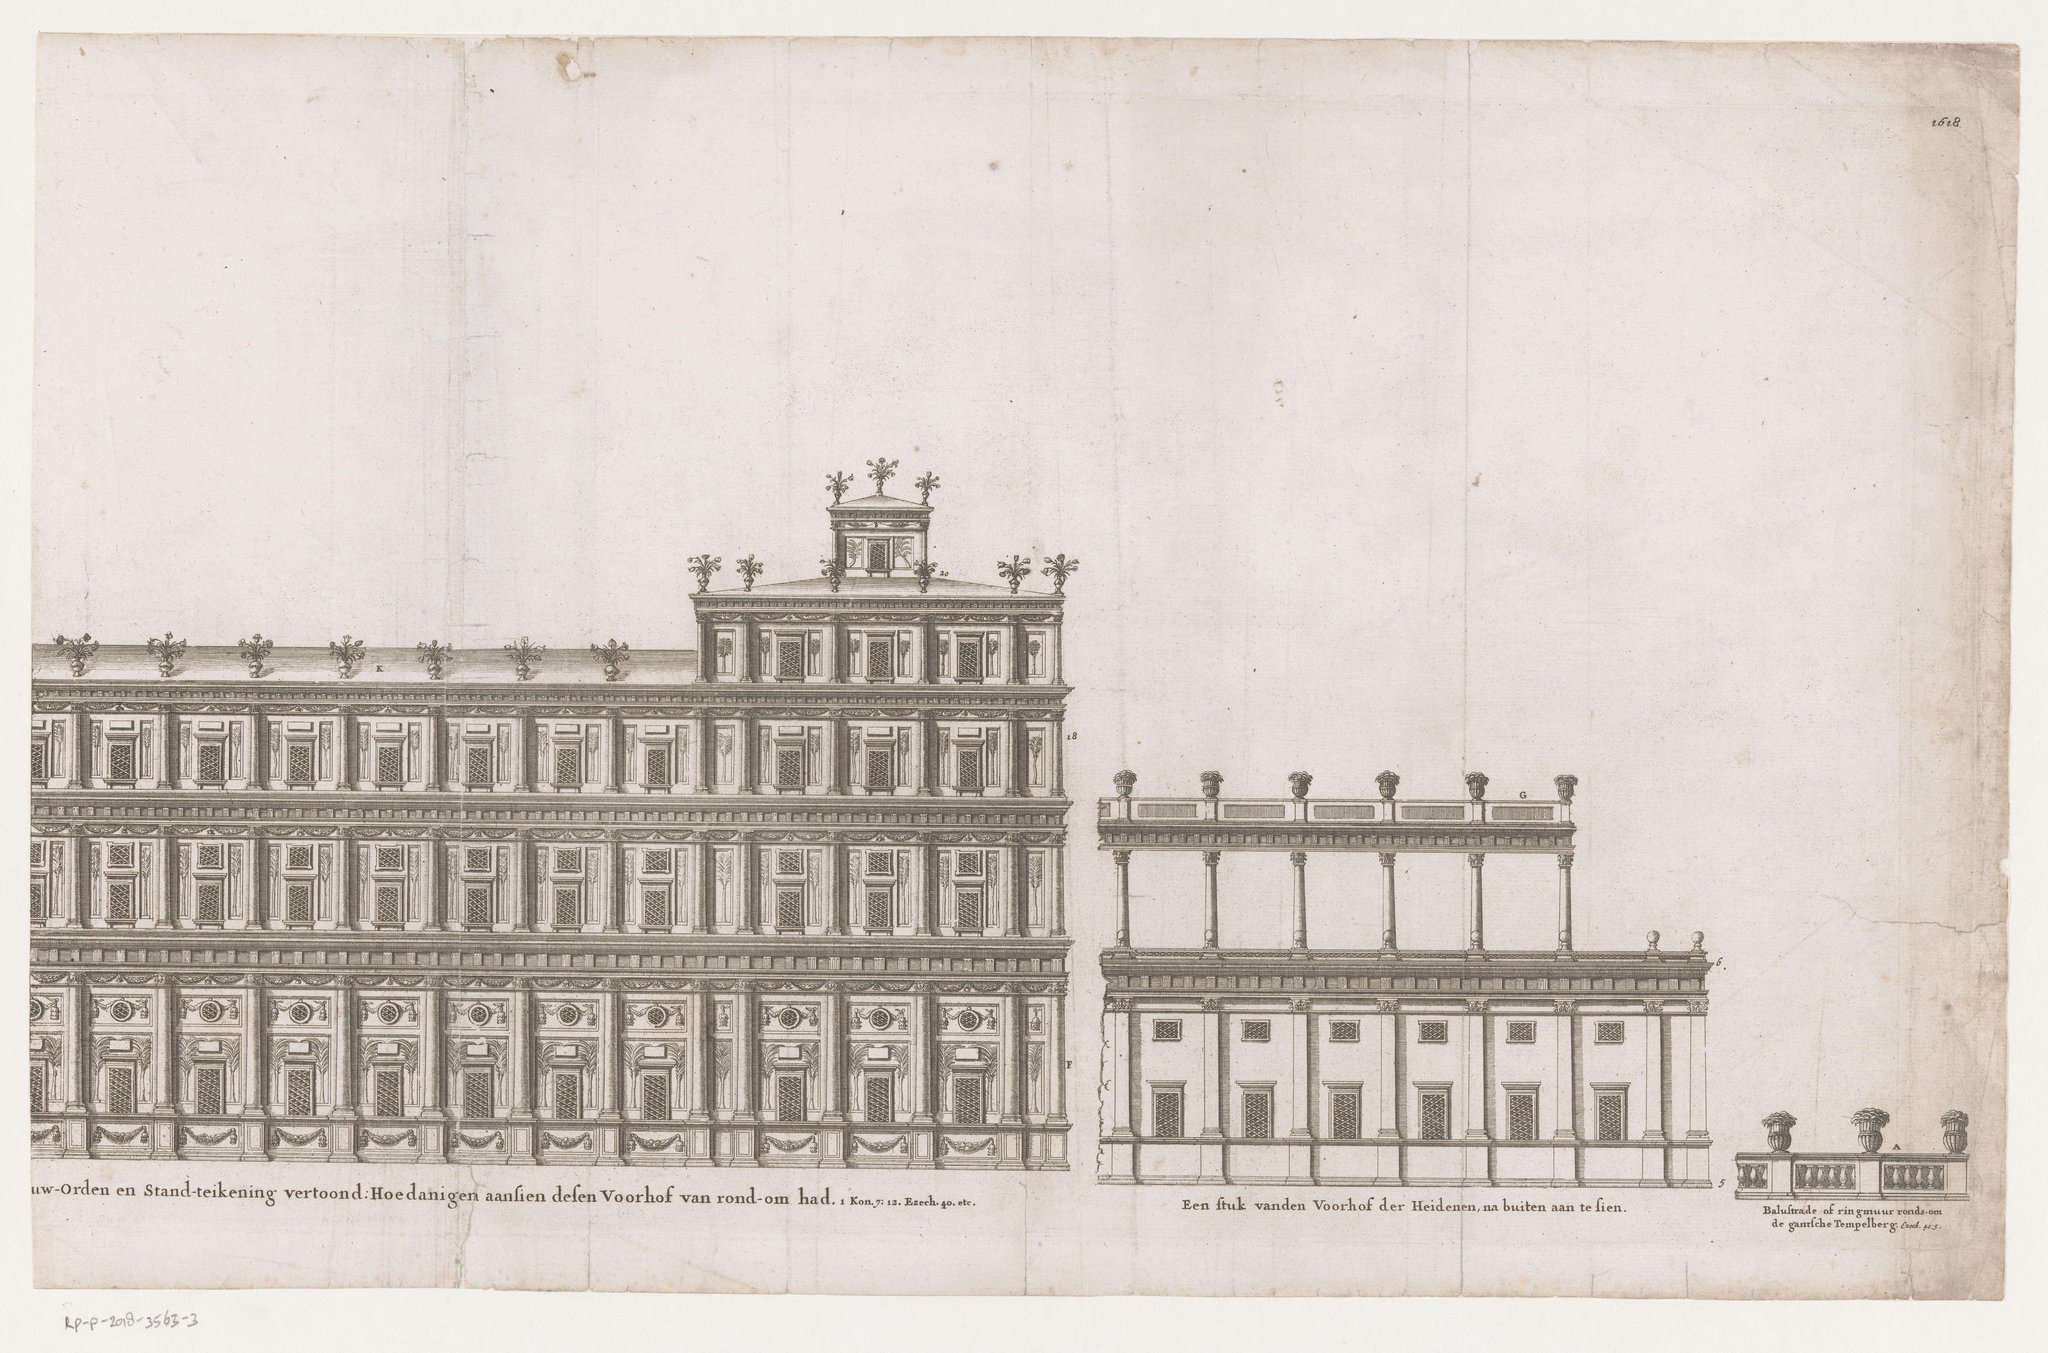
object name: print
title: Aanzicht op de tempel van Salomo volgens Villalpando (blad rechts)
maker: juan bautista villalpando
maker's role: architect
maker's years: 1552-1608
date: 1725-1727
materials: paper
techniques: etching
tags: temple of solomon (1 kings 5-9; 2 chronicles 2-7), exterior ~ architectural design or model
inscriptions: collector's mark: Lugt 2228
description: Prent verschenen in: Calmet, Augustin. Het algemeen groot historisch, oordeelkundig, chronologisch, geografisch en letterlyk naam- en woord-boek van den gantschen H. Bybel. Amsterdam: R. en J. Wetstein en W. Smith, 1725-1727.